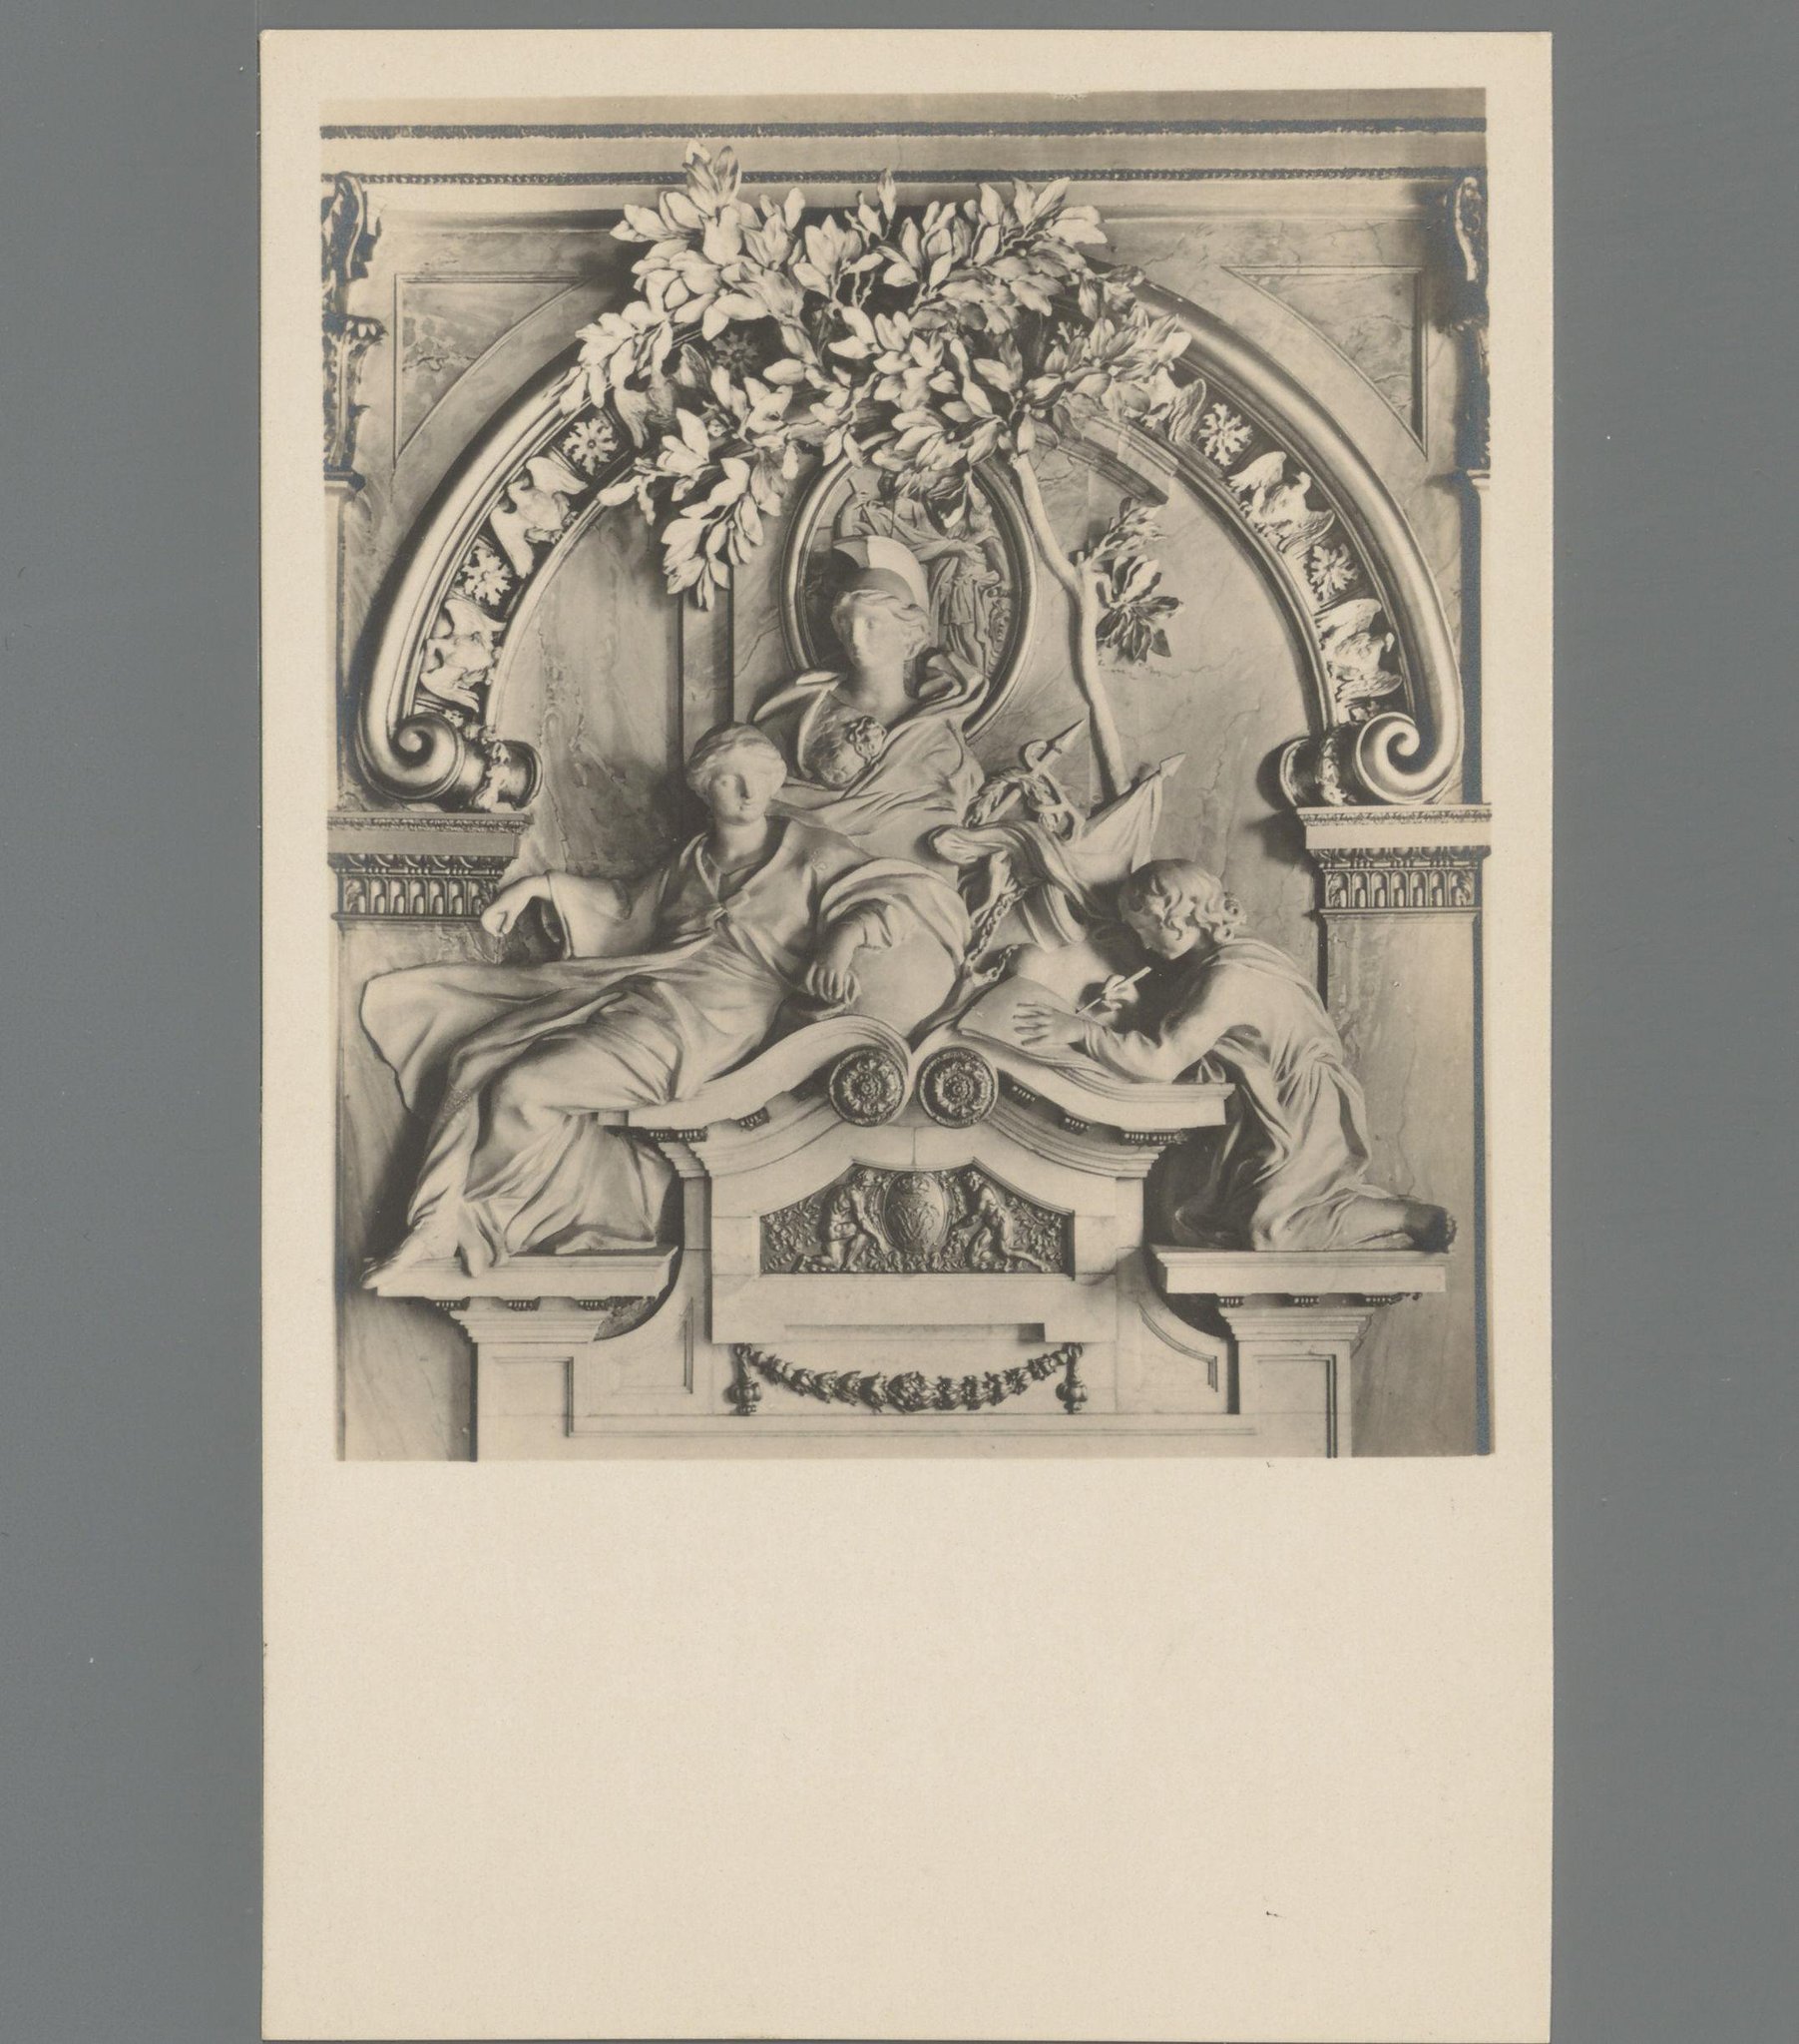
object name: ansichtkaart, prentbriefkaart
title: Berlin, Schloss. Paradekammern, Rittersaal. Andreas Schlüter: "Europa"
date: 1900-1930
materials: photographic support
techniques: photography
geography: berlin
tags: europe represented allegorically; 'europa' (ripa), castle, interior of the house